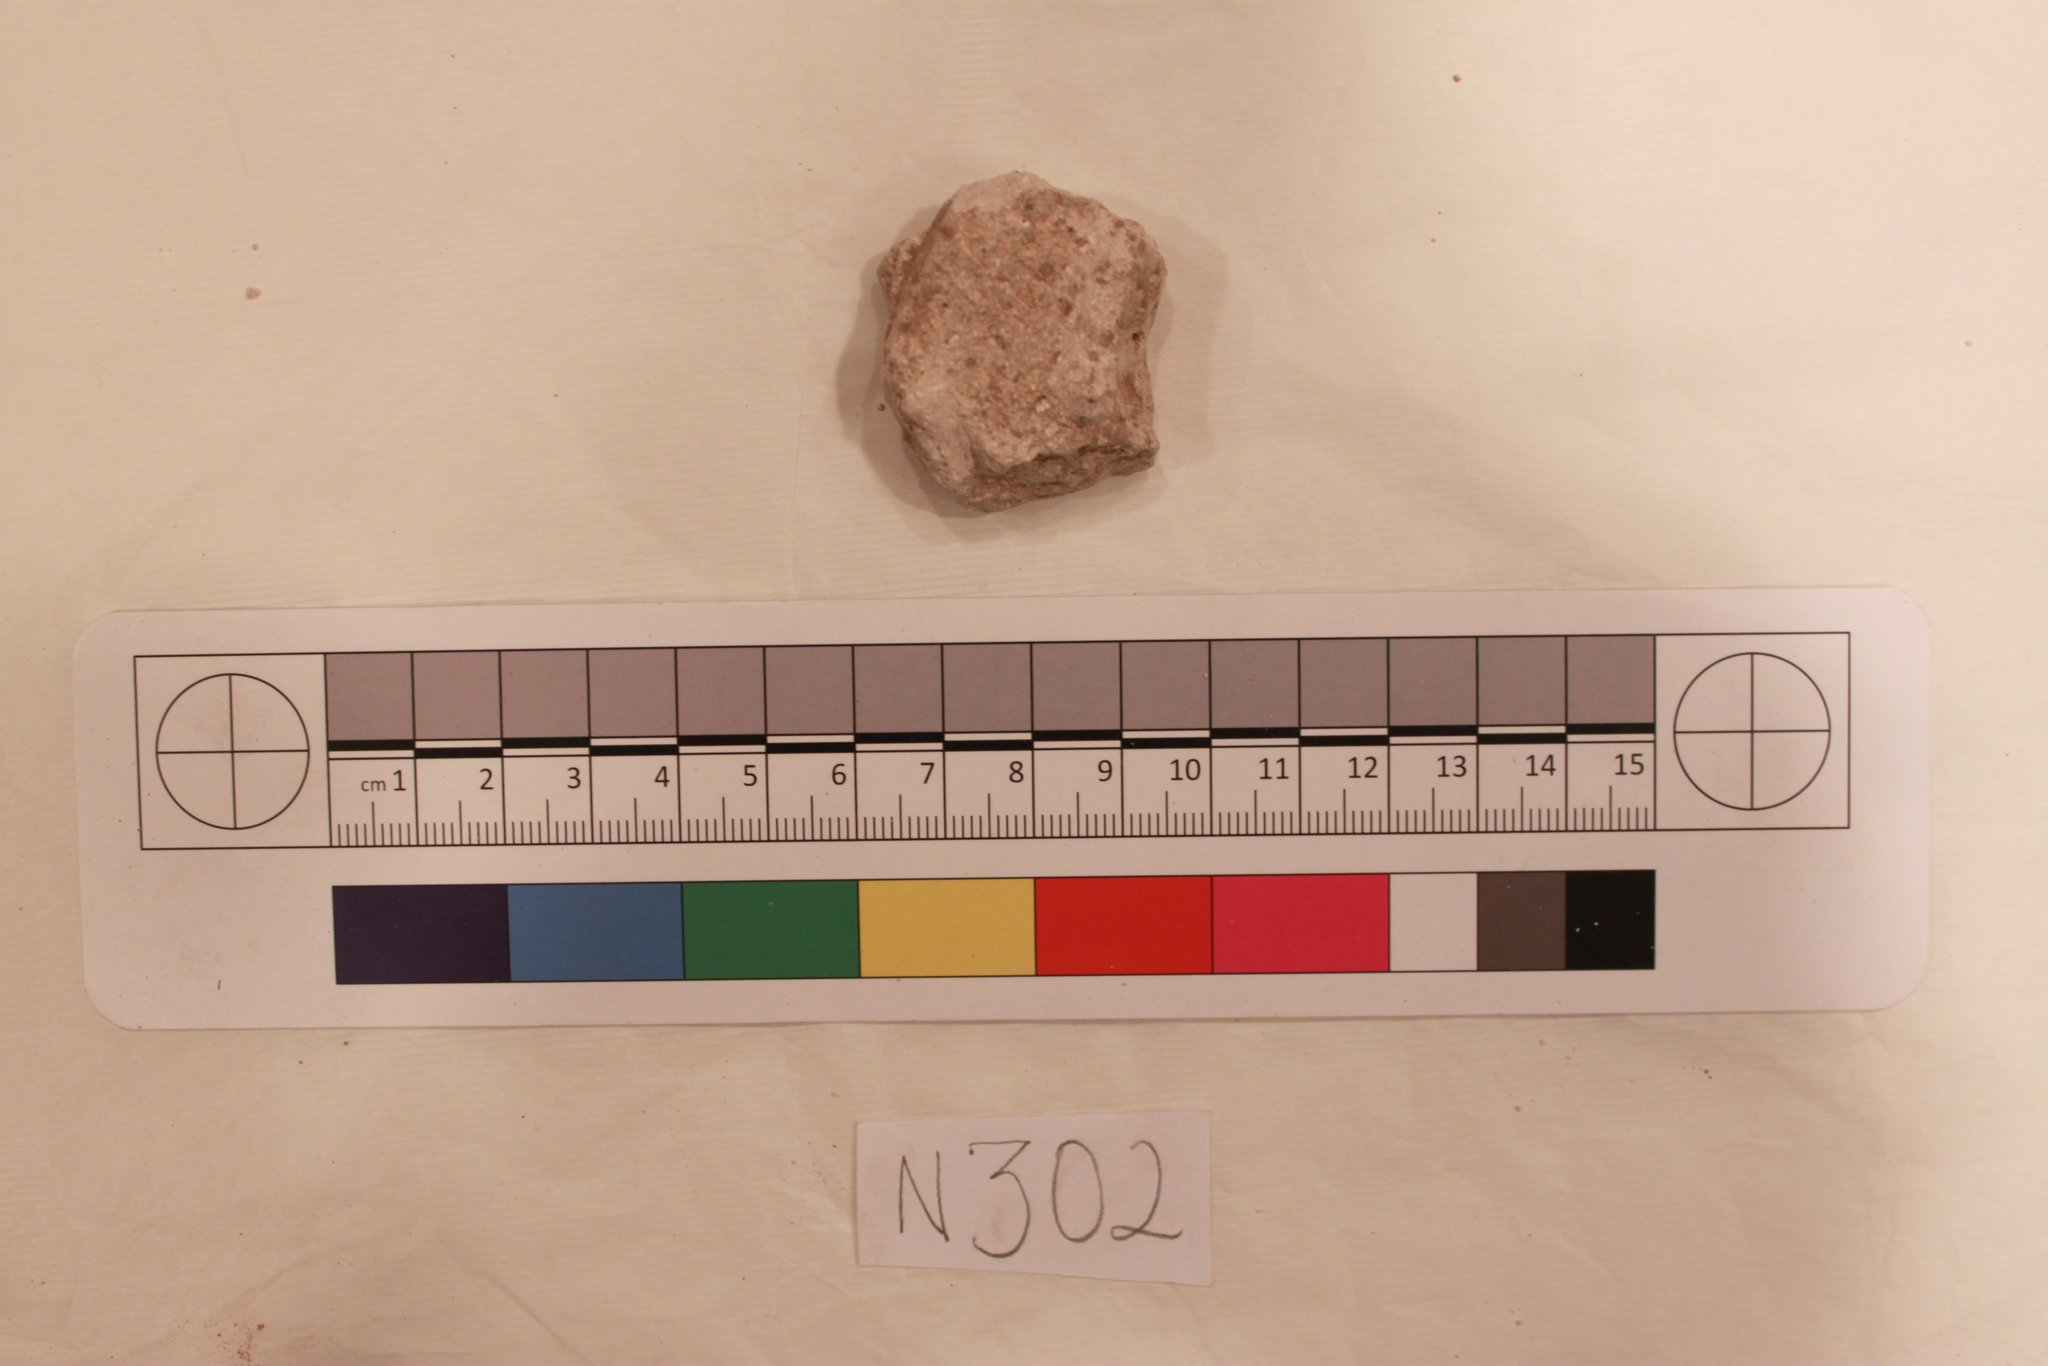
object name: fragment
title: Stucco Fragment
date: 701-1200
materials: plaster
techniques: carving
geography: iran